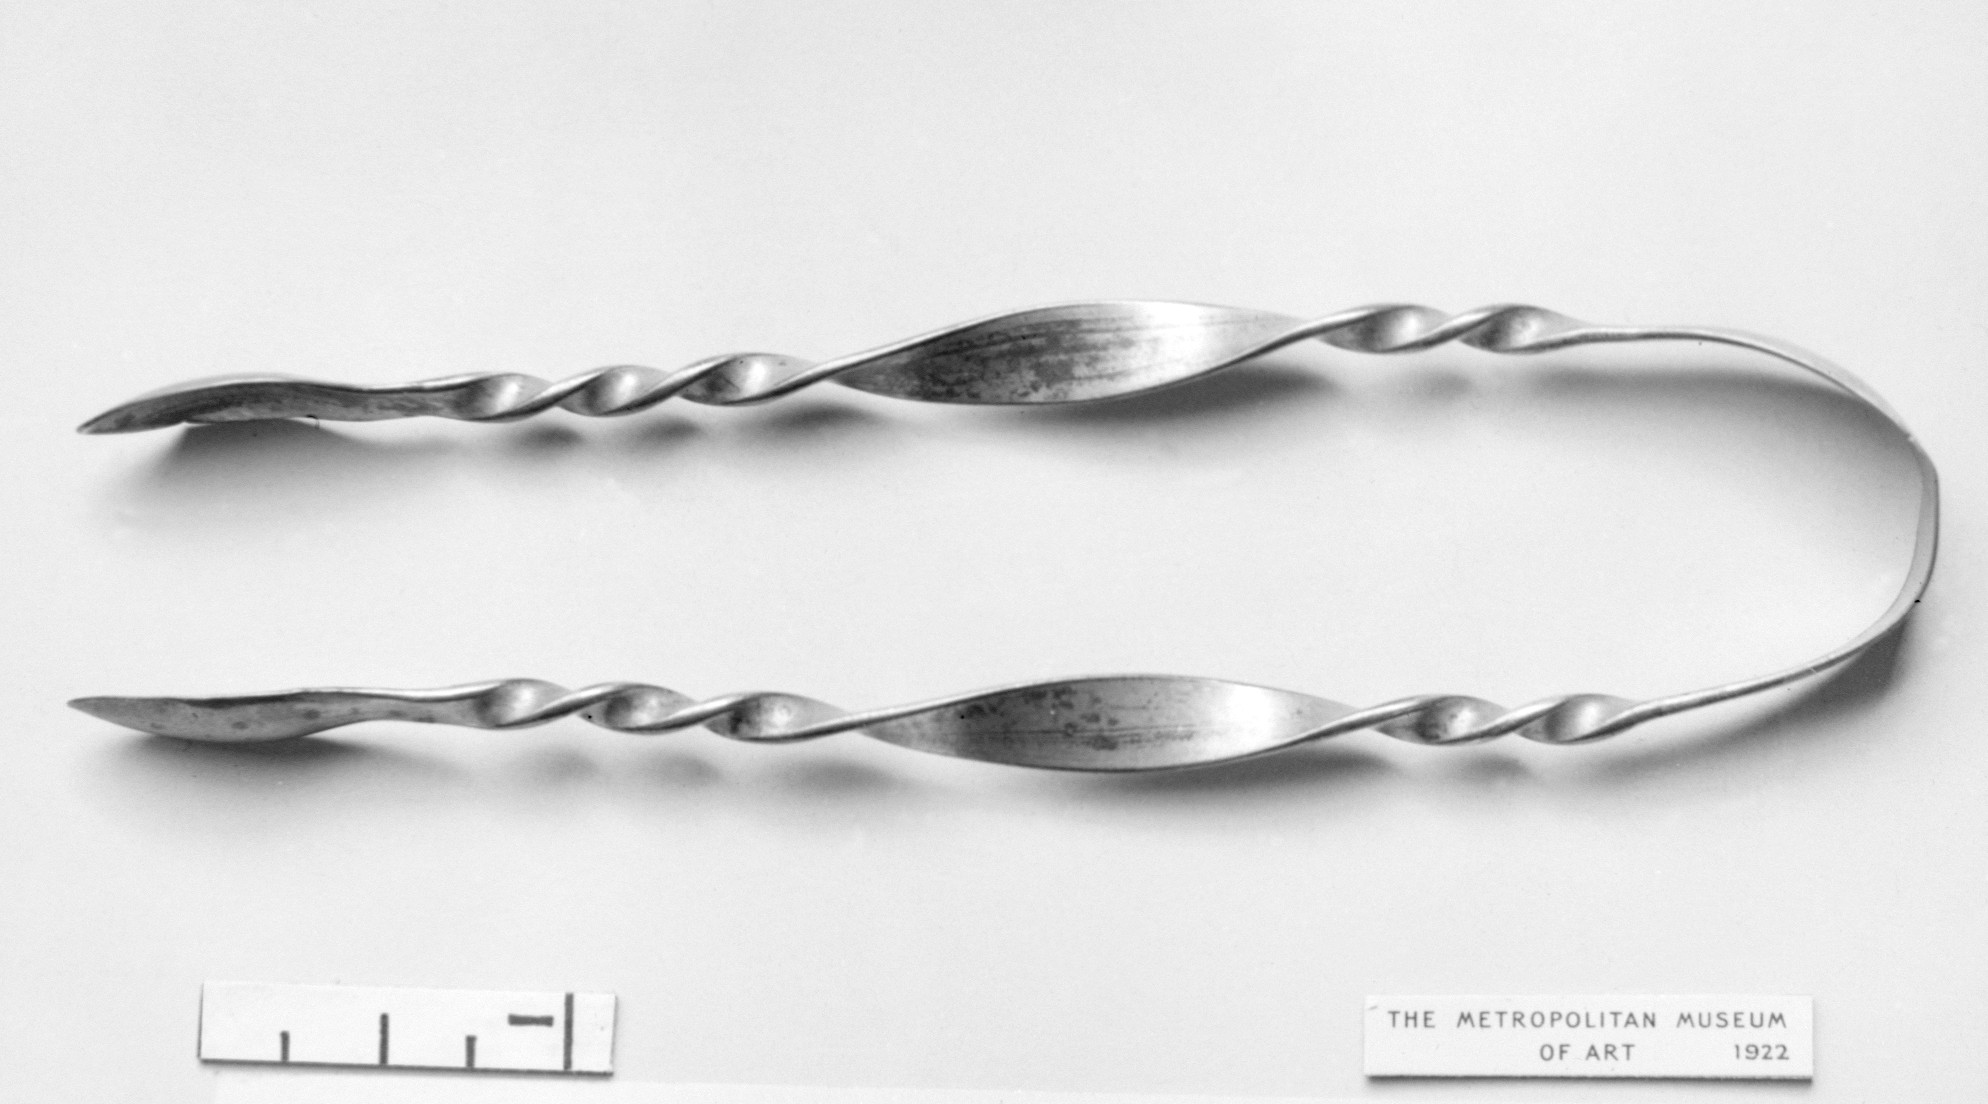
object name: sugar tongs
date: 1770-1790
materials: metal